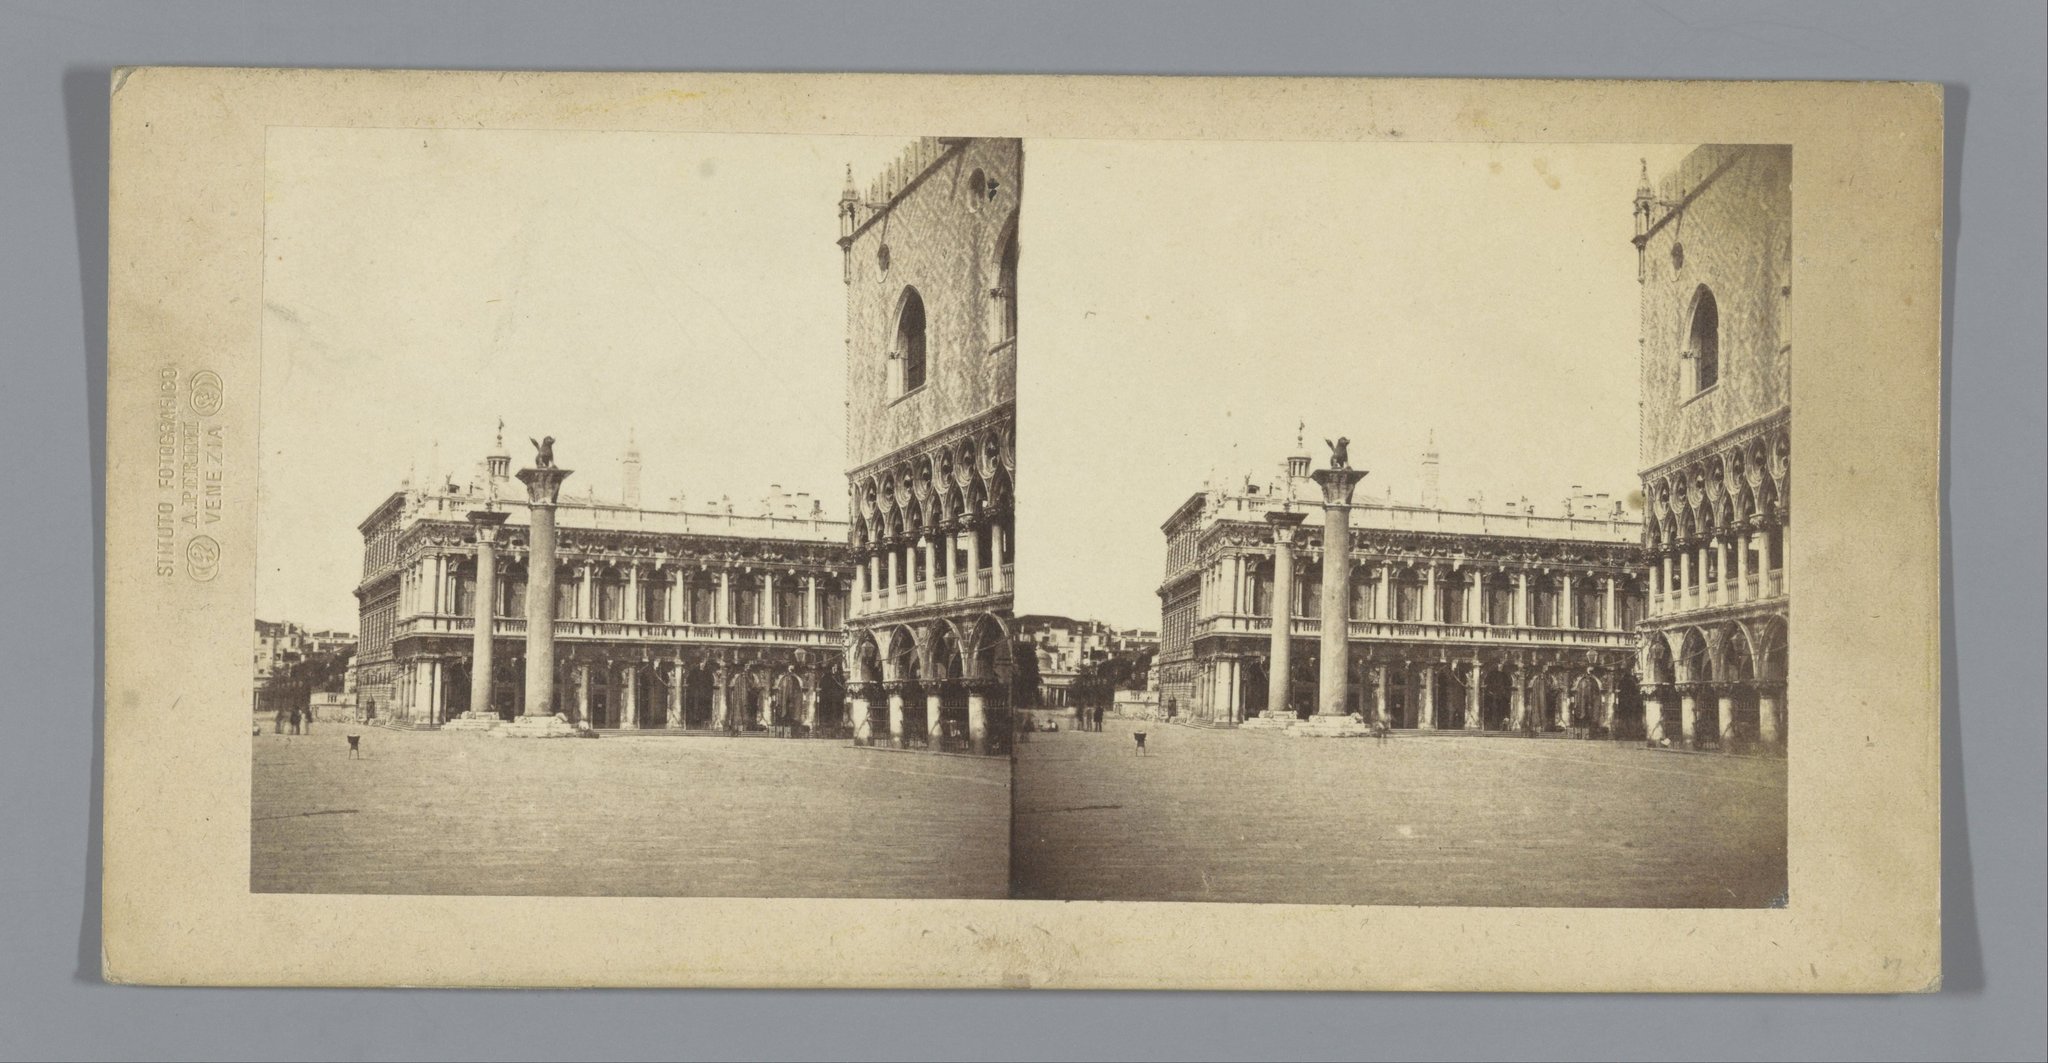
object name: stereograph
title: Gezicht op het San Marcoplein te Venetië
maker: antonio perini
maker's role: fotograaf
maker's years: 1830-1879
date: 1850-1870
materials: cardboard, photographic support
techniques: albumen print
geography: venice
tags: square, place, circus, etc., column, pillar ~ architecture, façade (of house or building)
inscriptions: name: ‘STITUTO FOTOGRAFICO A.PERINI VENEZIA’